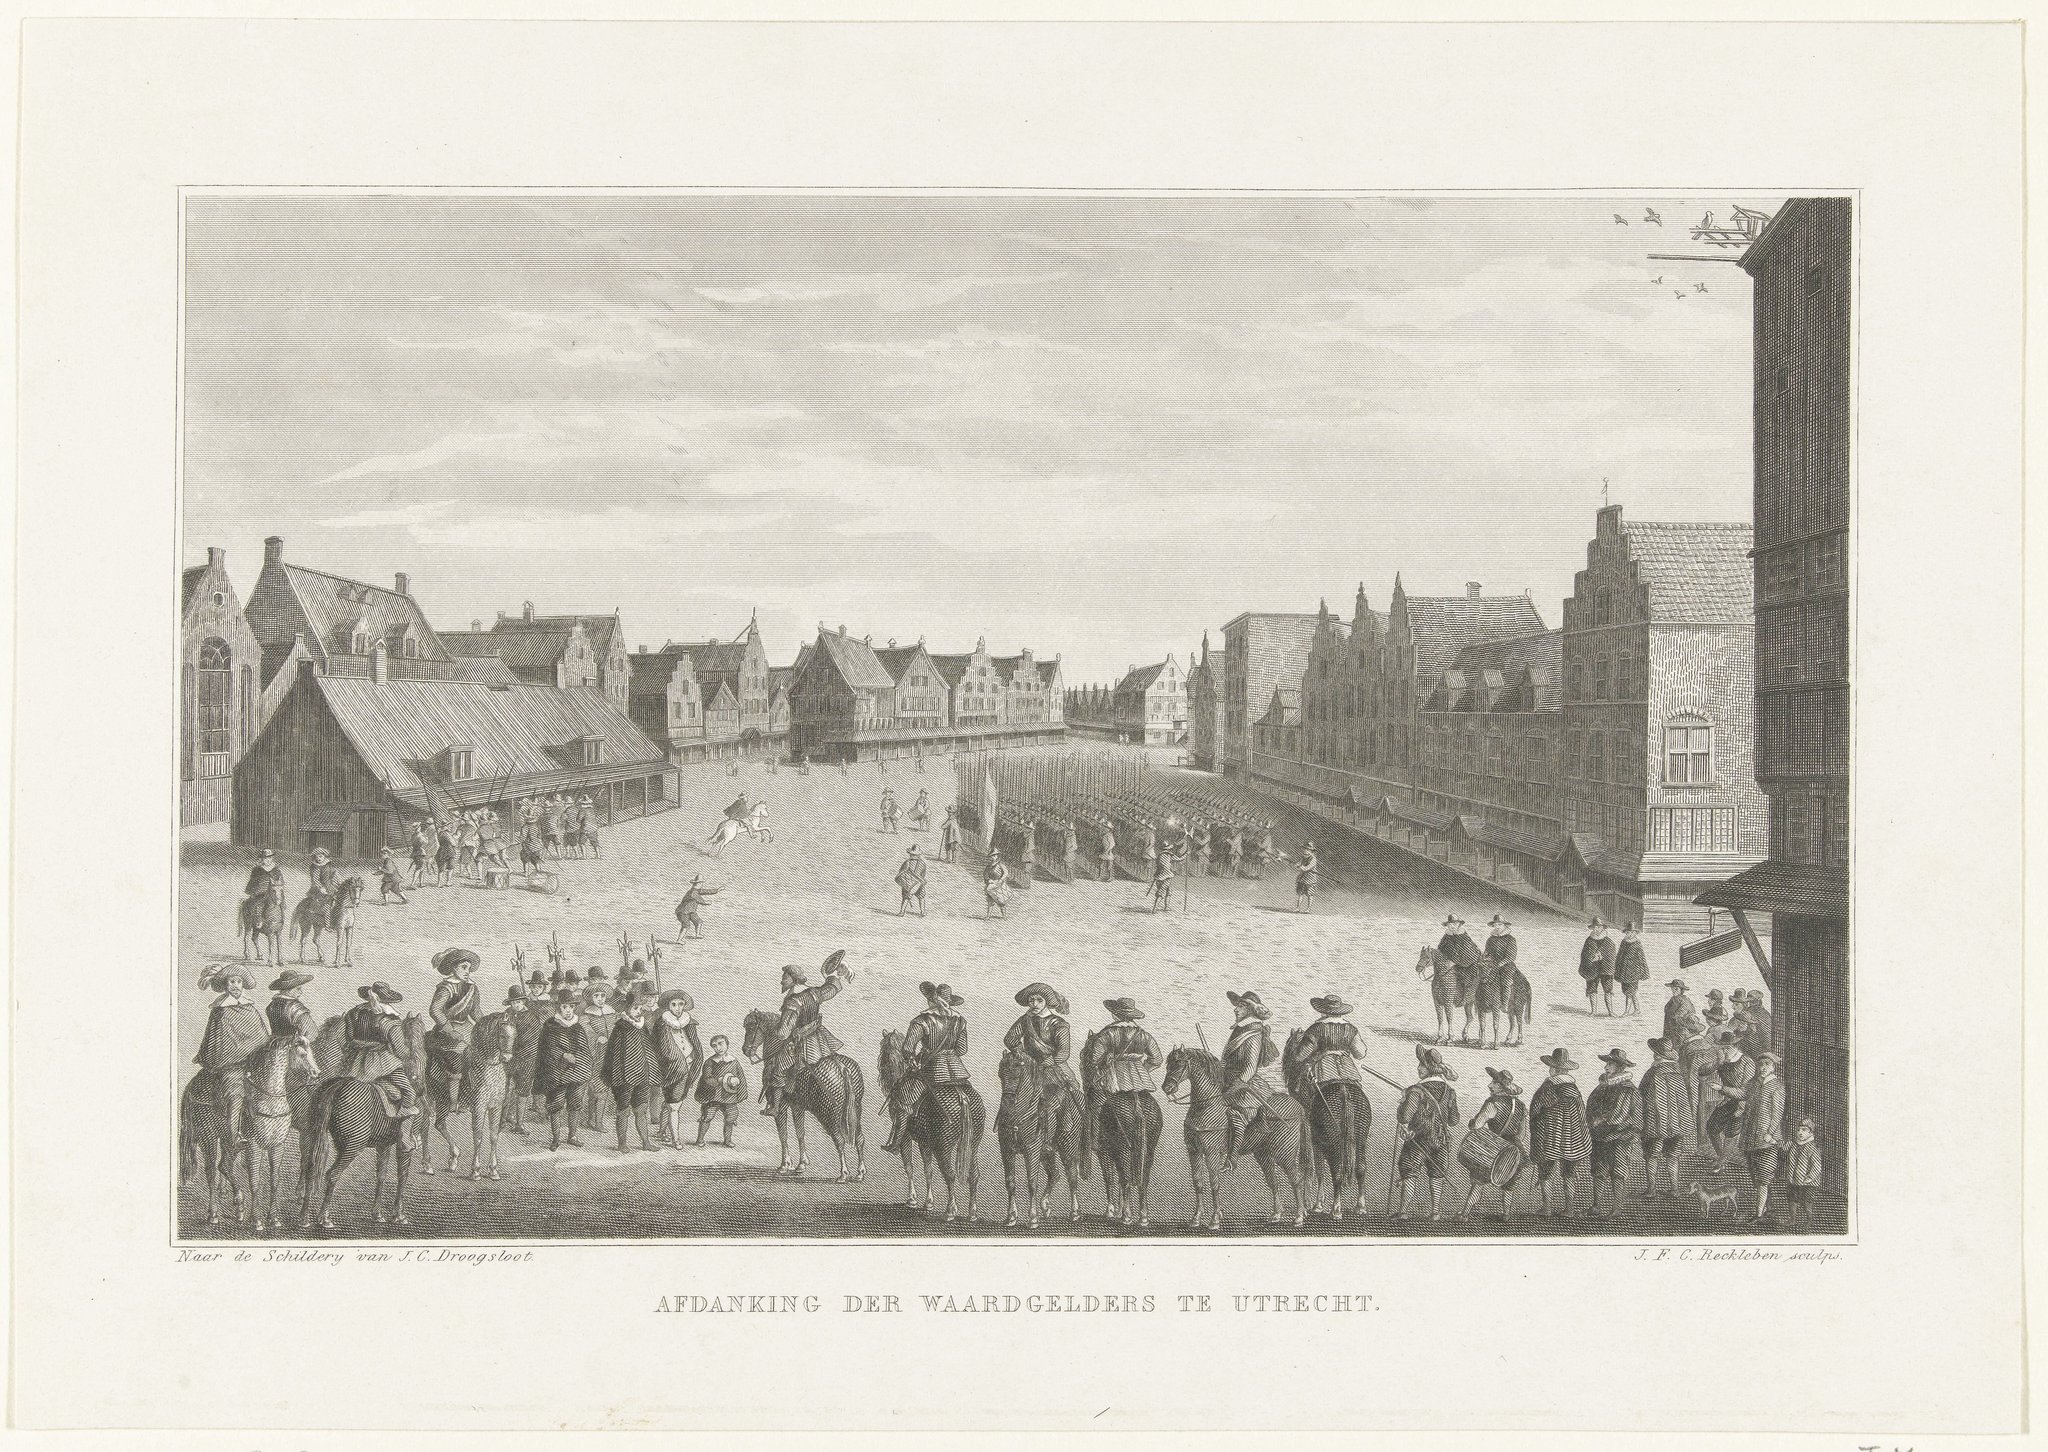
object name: history print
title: Afdanking der Waardgelders te Utrecht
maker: jan frederik christiaan reckleben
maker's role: print maker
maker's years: 1819-1879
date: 1855-1857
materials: paper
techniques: engraving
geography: netherlands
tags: the hague, maurice (prince of orange), demobilization, warfare; military affairs (+ mercenary troops, e.g.: lansquenets), assembling of military forces; mobilization, troop concentration, etc.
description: Gebruikt als illustratie in: J.P. Arend, Algemeene geschiedenis des vaderlands, Amsterdam, 5 delen, 1840-1882, deel 3.2 (1857), p. 834/835. Naar het schilderij in de collectie van het Rijksmuseum, Amsterdam (SK-A-606).